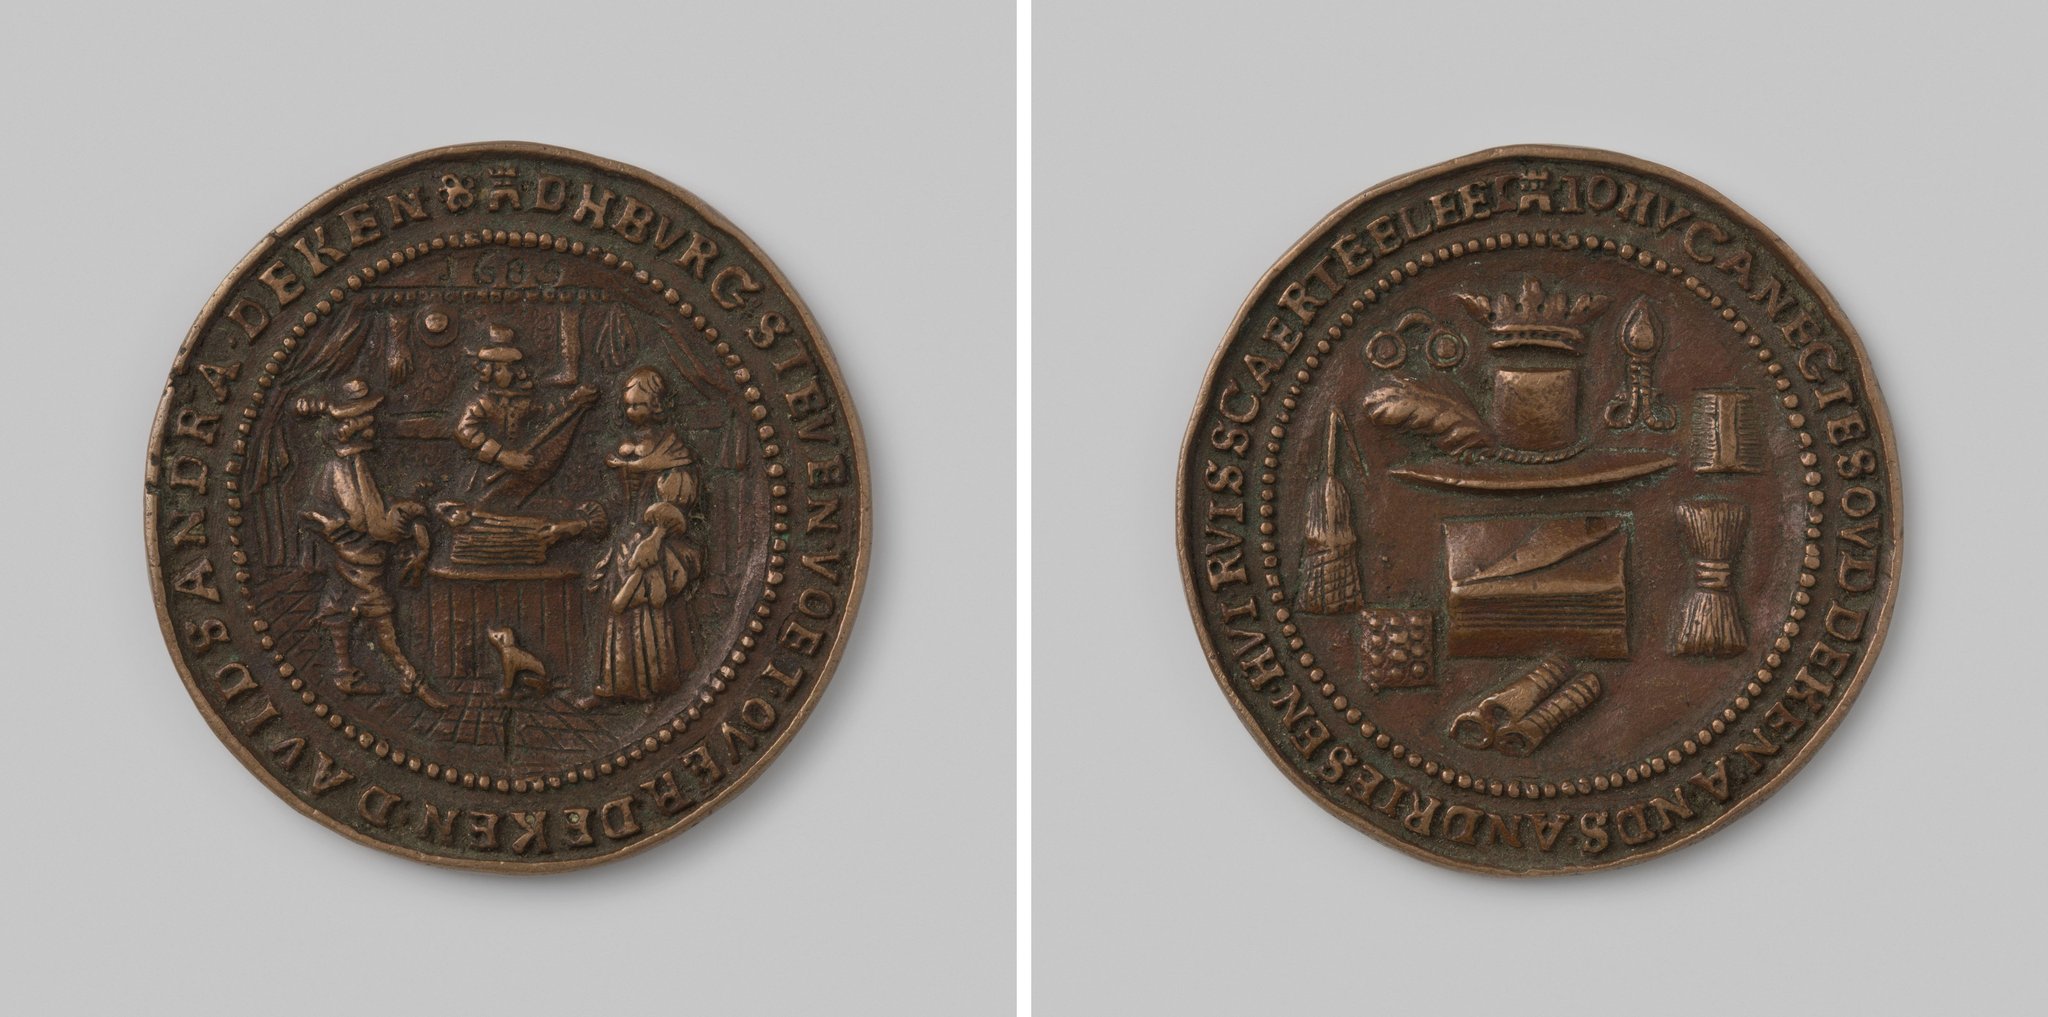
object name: medal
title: Presentiepenning van het Zijdelakerkopers- en Kramersgilde te Middelburg, 1689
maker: jan stangeniete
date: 1689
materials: brass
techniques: casting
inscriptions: inscription: ‘1’, circumscription: ‘(burcht) IOH V CANEGIES OVD DEKEN ANDS ANDRIESEN HVI RVISSCAERT BELEED’, circumscription: ‘(burcht) D H BURG STEVEN VOET OVERDEKEN DAVID SANDRA DEKEN (rozet)’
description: Gegoten messing penning, op de voorzijde het interieur van een lakenwinkel, bovenaan 1689, onderaan gegraveerd het getal 1, met omschrift, op de keerzijde kramerswaren: bril, gekroonde hoed met pluim, snuiter, kam, kwast, kaart knopen, etc. met omschrift